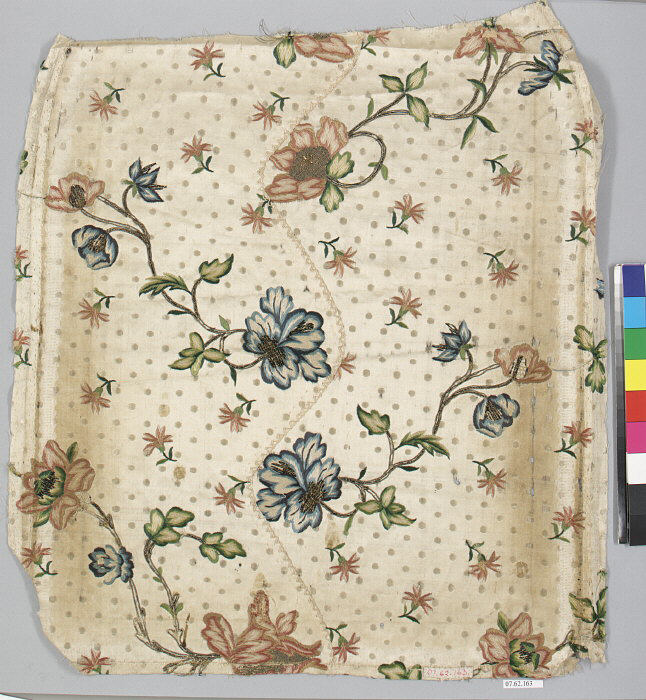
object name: embroidery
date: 1701-1800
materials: metal thread, silk